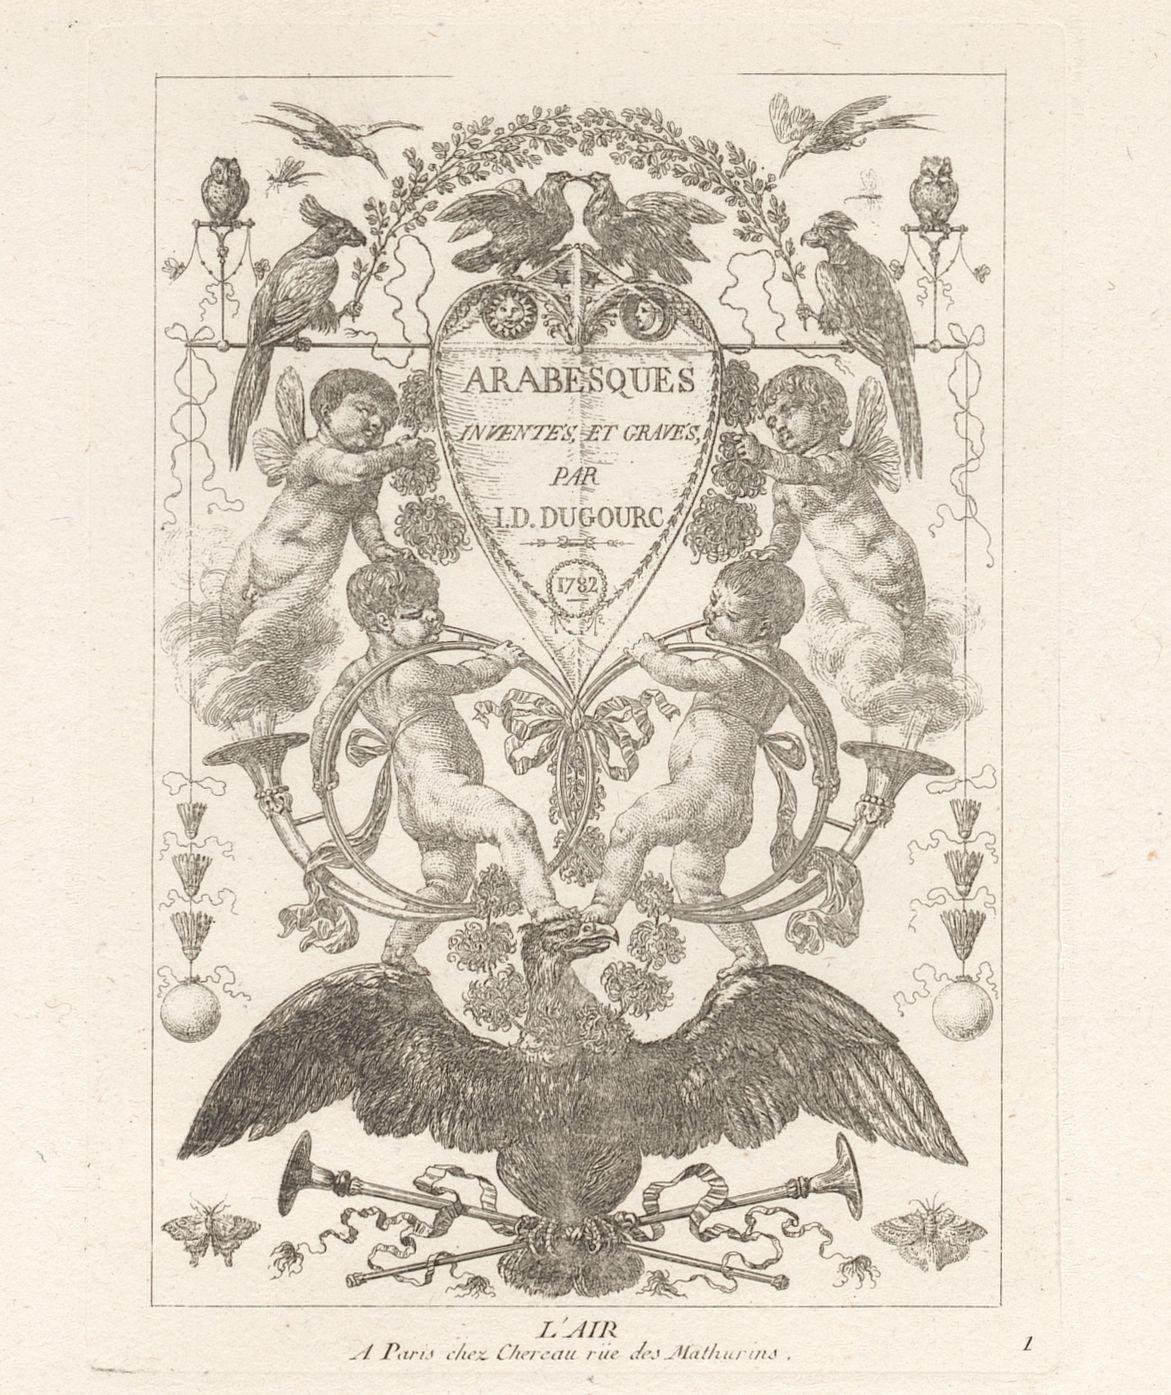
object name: ornament print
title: Arabesques inventes et graved par I.D. Dugourc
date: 1782-1802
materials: paper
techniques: etching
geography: paris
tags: predatory birds: eagle, ornament ~ arabesque, horn, trumpet, cornet, trombone, tuba, air (one of the four elements), birds, cupids: 'amores', 'amoretti', 'putti'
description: Doordat dit album bestaat uit meerdere, deels eerder uitgegeven prentreeksen, is de datering niet consequent. Het geheel is op de titelpagina gedateerd op 1802. Deze reeks is gedateerd op 1782. De serietitel voor het gehele werk is "Recueil d'arabesques, contenant les loges du Vatican". De andere serietitel is de titel van de specifieke reeks binnen het geheel.